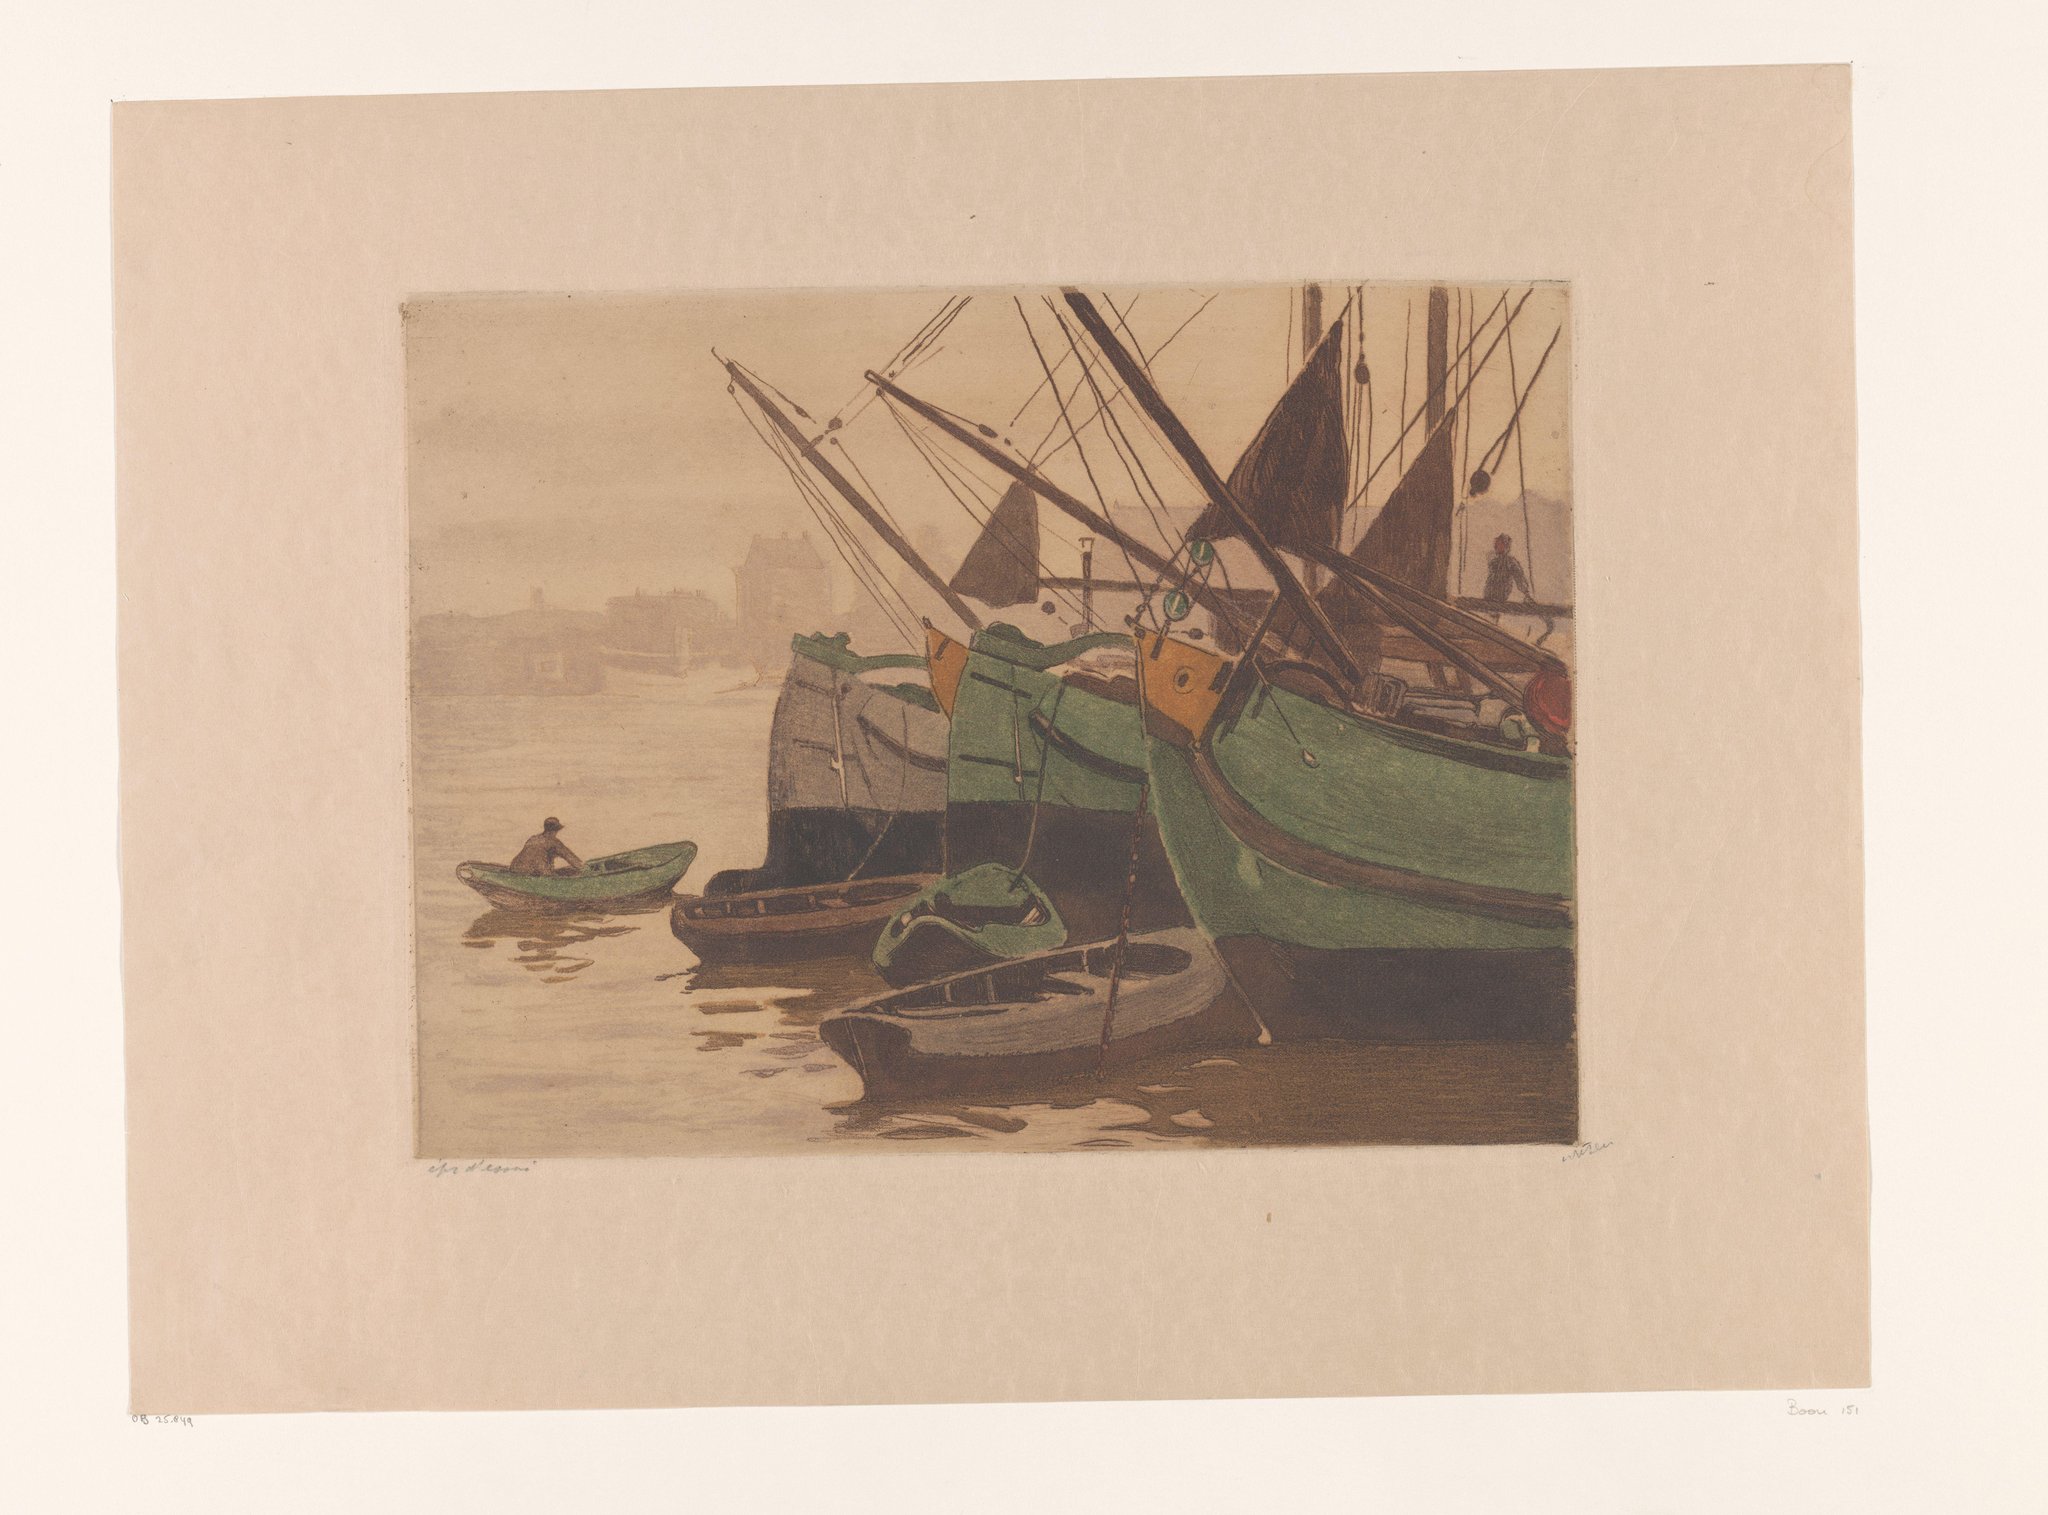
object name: print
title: Drie turfschepen met roeiboten in het IJ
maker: willem witsen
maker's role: draughtsman, painter, print maker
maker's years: 1860-1923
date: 1910-1911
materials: paper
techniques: aquatint, drypoint, soft ground etching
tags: urban housing, sailing-ship, sailing-boat, rowing-boat, canoe, etc.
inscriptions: annotation: ‘érp. d'essai’